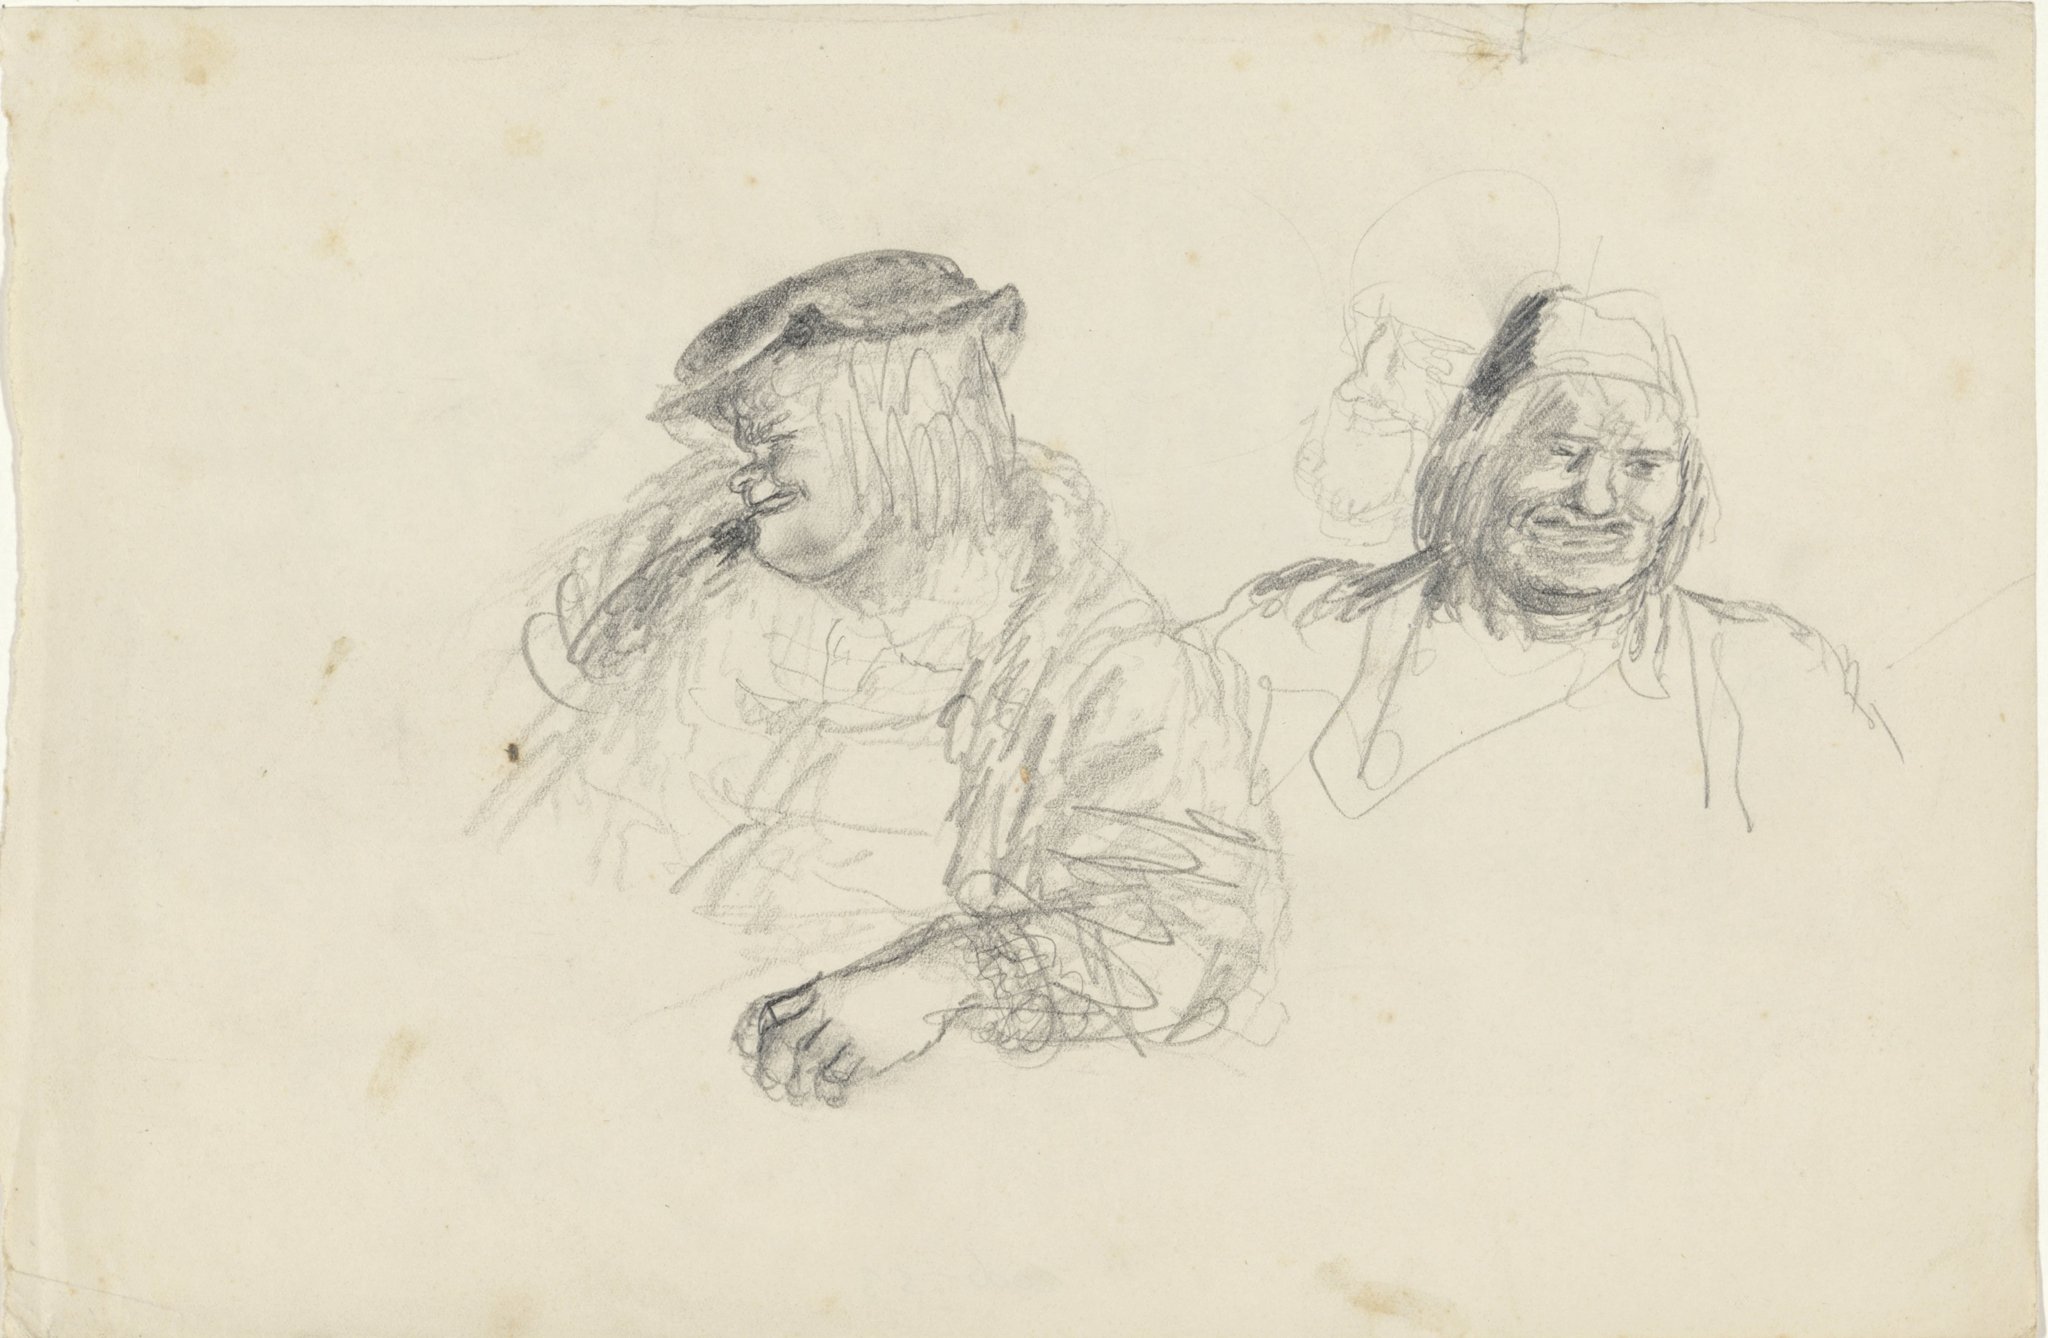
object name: drawing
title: Twee mannen met een hoofddeksel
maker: henk henriët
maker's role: draughtsman, print maker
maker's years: 1903-1945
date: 1936-1940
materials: paper, pencil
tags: caricatures (human types), adult man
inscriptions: collector's mark: Lugt 2228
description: Deze tekening is mogelijk een ontwerp voor een illustratie bij het boek 'Gargantua en Pantagruel' van François Rabelais.